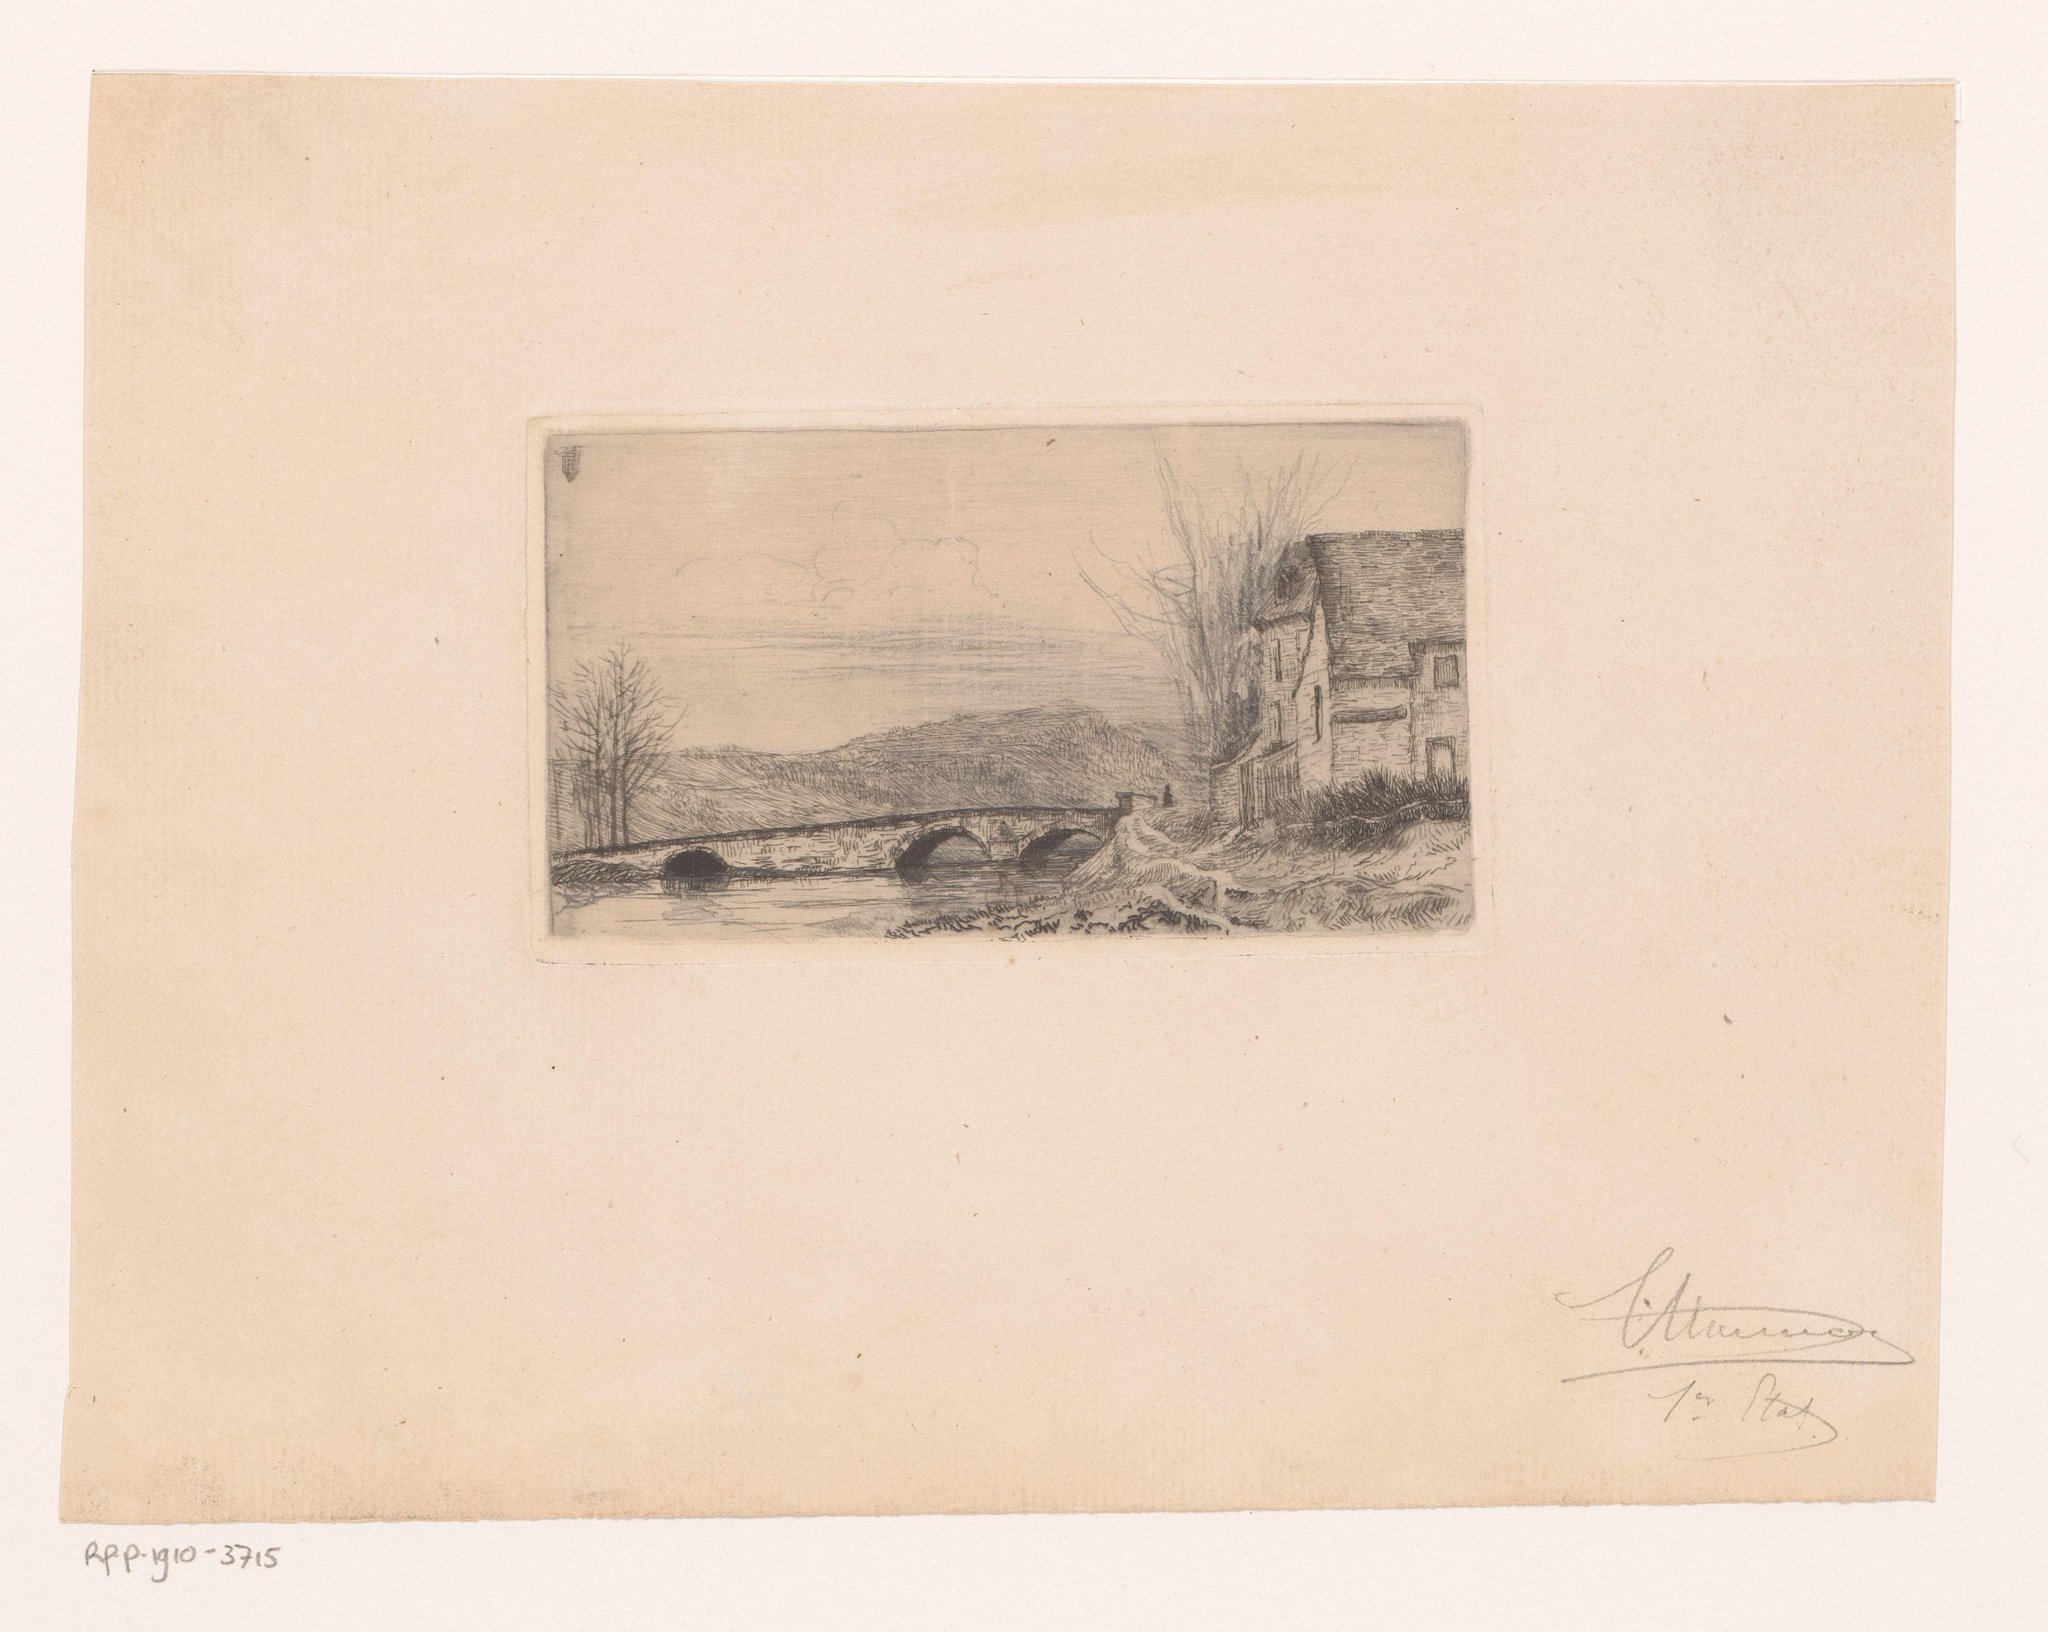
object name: print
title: Landschap met brug en een huis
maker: theodoor hannon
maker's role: print maker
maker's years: 1851-1917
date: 1876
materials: paper, pencil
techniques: etching, intaglio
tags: landscape with bridge, viaduct or aqueduct, farm or solitary house in landscape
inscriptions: collector's mark: Lugt 2228, inscription: ‘1e etat’